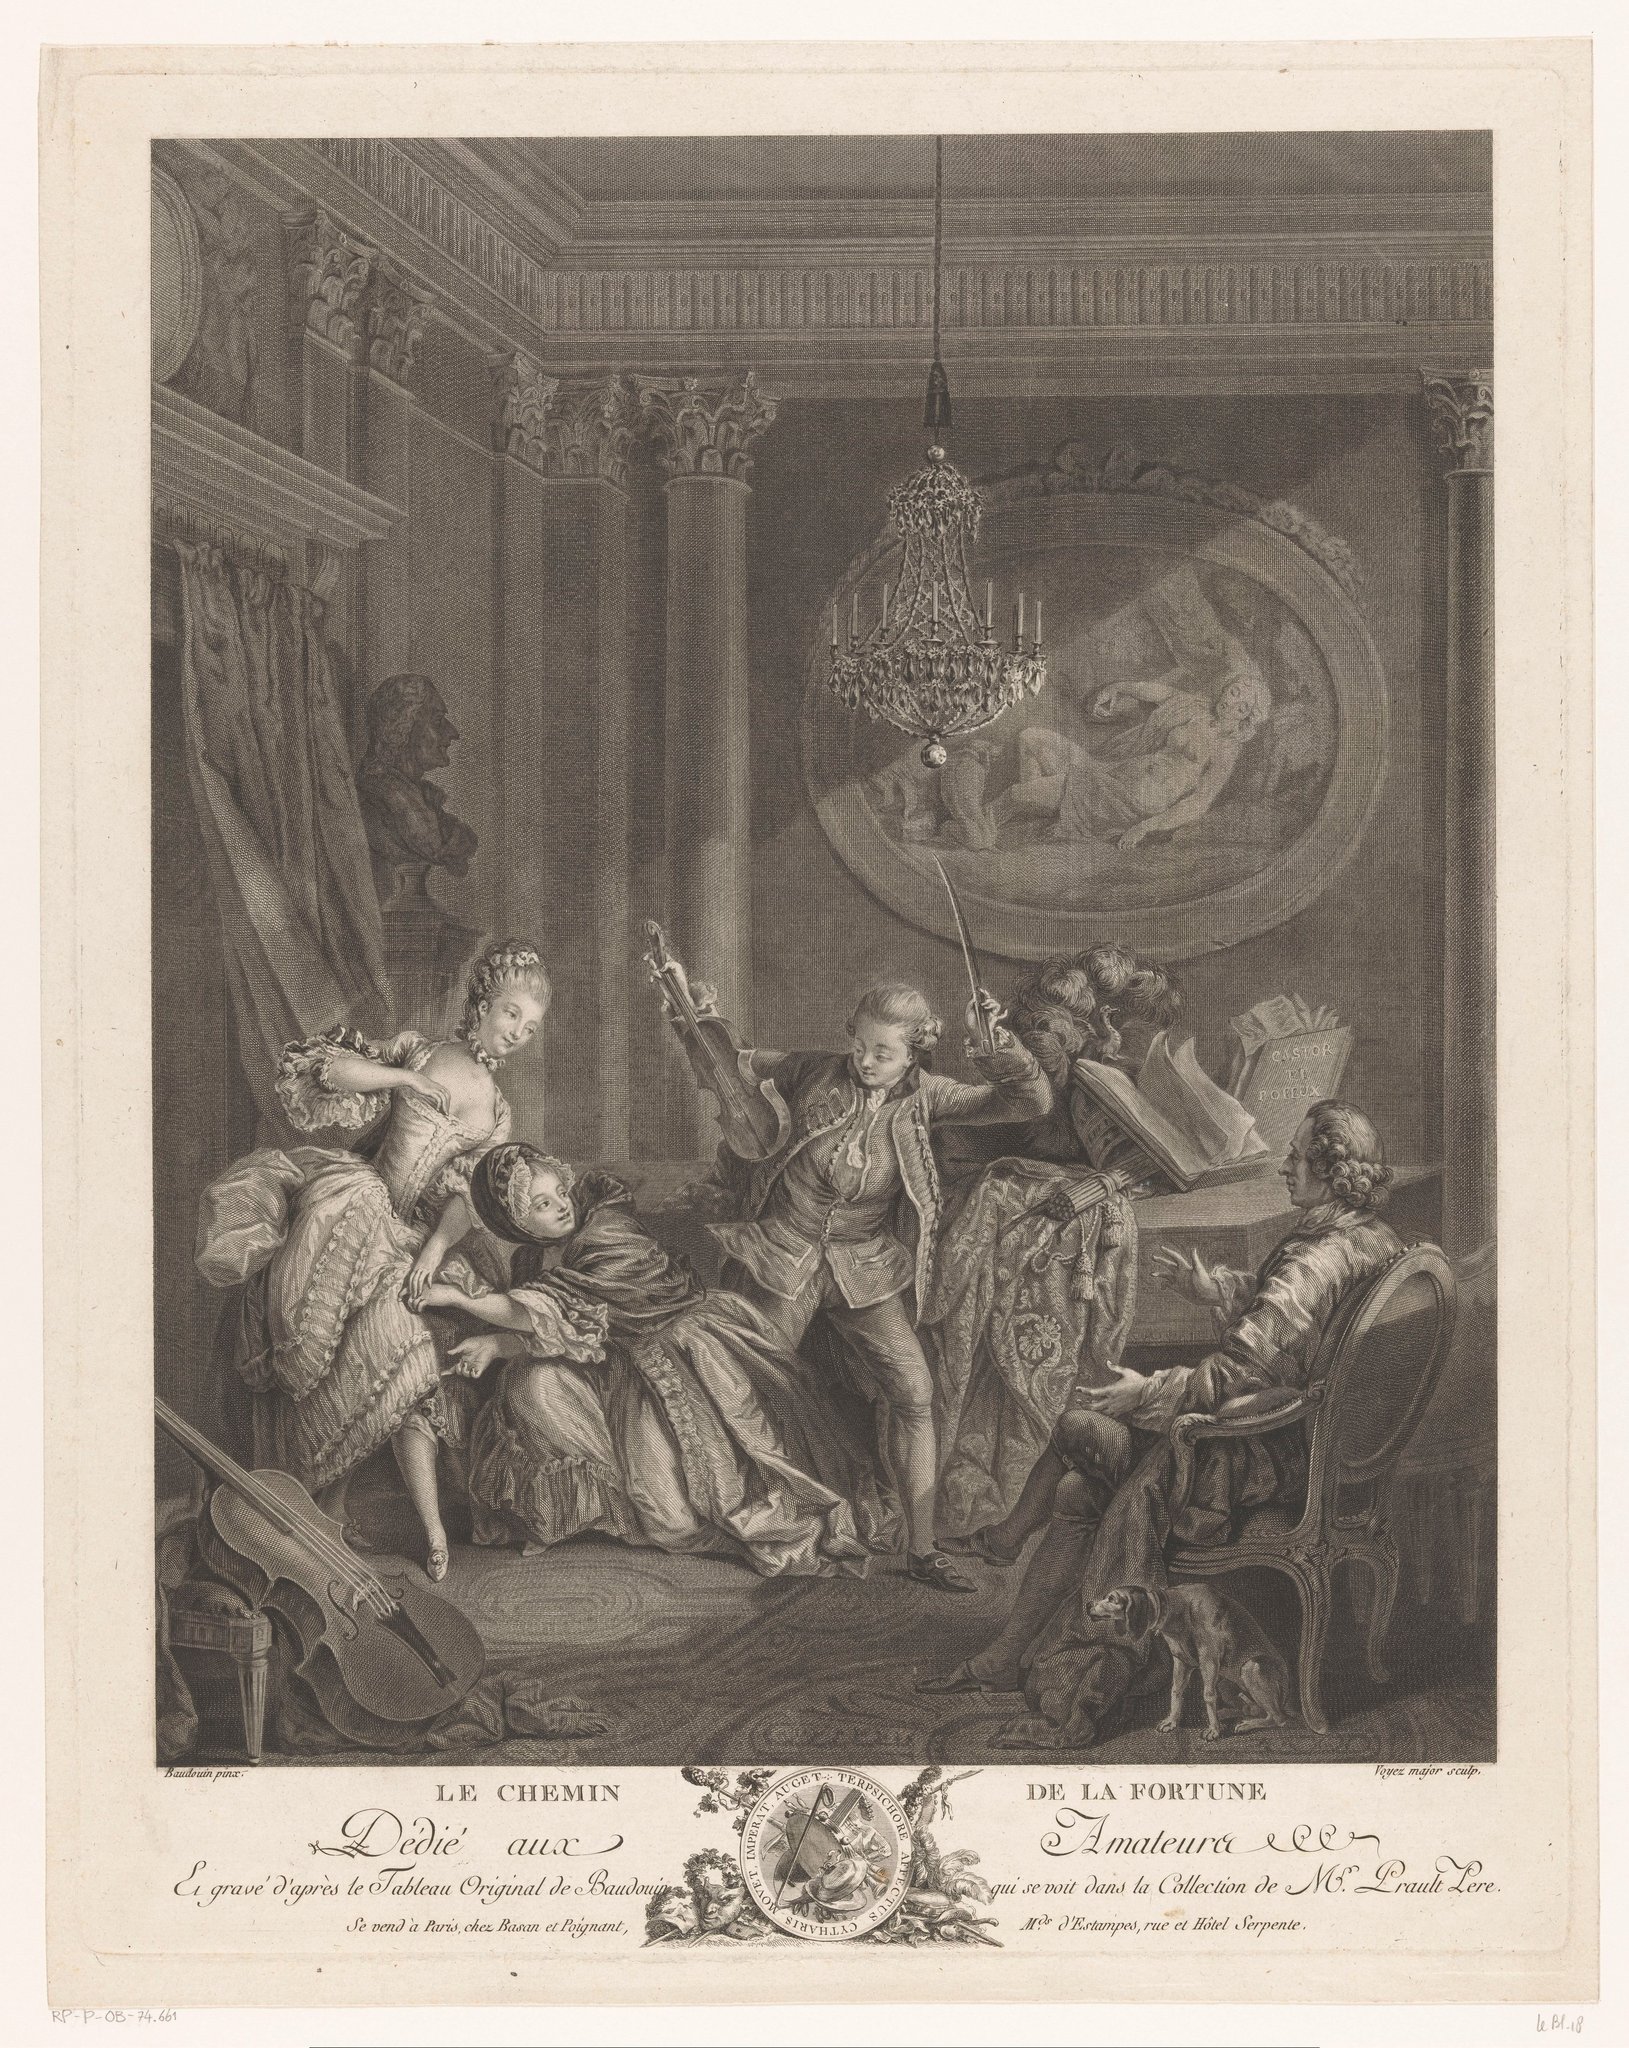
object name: print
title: Een violist en twee jonge vrouwen in een interieur, een zittende man kijkt toe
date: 1778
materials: paper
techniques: engraving, etching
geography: france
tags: tucking up one's clothes, violin, fiddle, clothes, costume (+ women's clothes), viola, violoncello; double bass, clothes, costume (+ men's clothes)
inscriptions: collector's mark: Lugt 2228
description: Een jonge violist staat met viool en stok in opgeheven handen in een vertrek en kijkt naar het been van een jongedame, die haar rok ophoudt. Een tweede dame zit op haar knieën en wijst naar het ontblote onderbeen. Rechts in een leunstoel een oudere heer die toekijkt. Op de tafel rechtsachter een kleed, een helm en enkele boeken. Op een van de boeken de titel Castor en Pollux. Linksvoor een cello tegen een taboeret. Aan de achterwand een schilderij in ovale lijst met de voorstelling van een slapende, halfnaakte vrouw. Aan het plafond een kroonluchter.